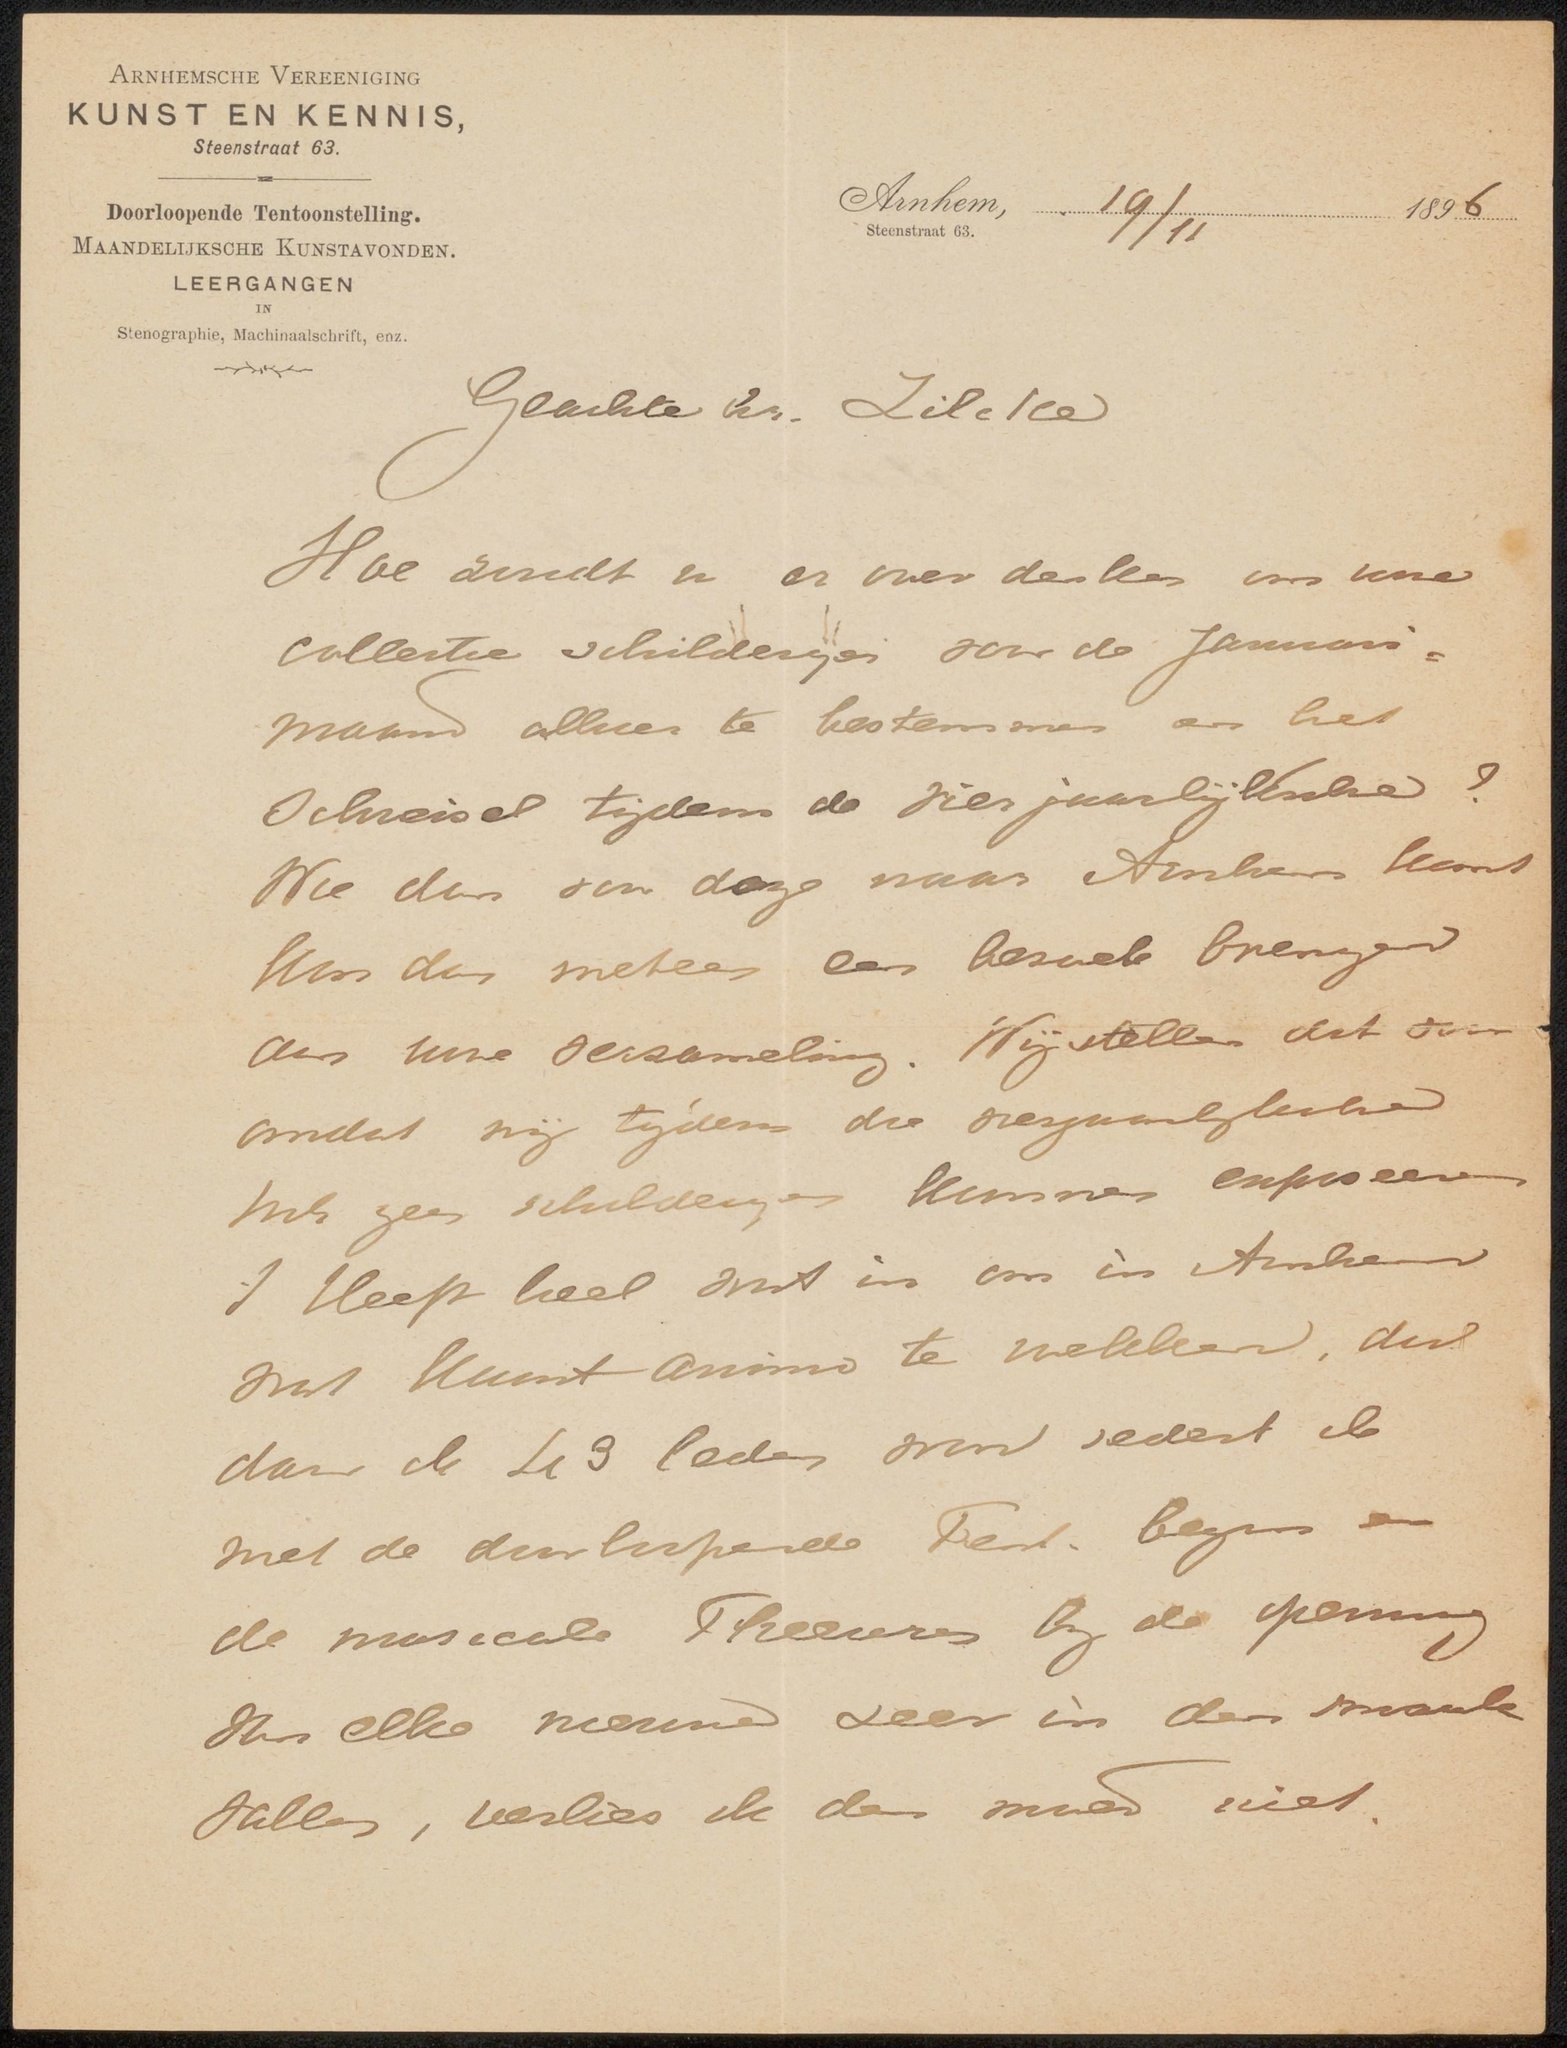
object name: letter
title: Brief aan Philip Zilcken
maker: christina elizabeth perk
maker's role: painter, sculptor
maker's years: 1833-1906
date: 1896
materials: ink, paper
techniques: pen, printing, writing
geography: arnhem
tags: print maker, karel petrus cornelis de bazel, amsterdam, brussels, draughtsman, david oyens, mathieu lauweriks, the hague, philip zilcken, applied arts, arts and crafts; industrial design, music, painting (including book-illumination, miniature-painting), exhibition ~ art, arnhem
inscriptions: collector's mark: ‘RPK’